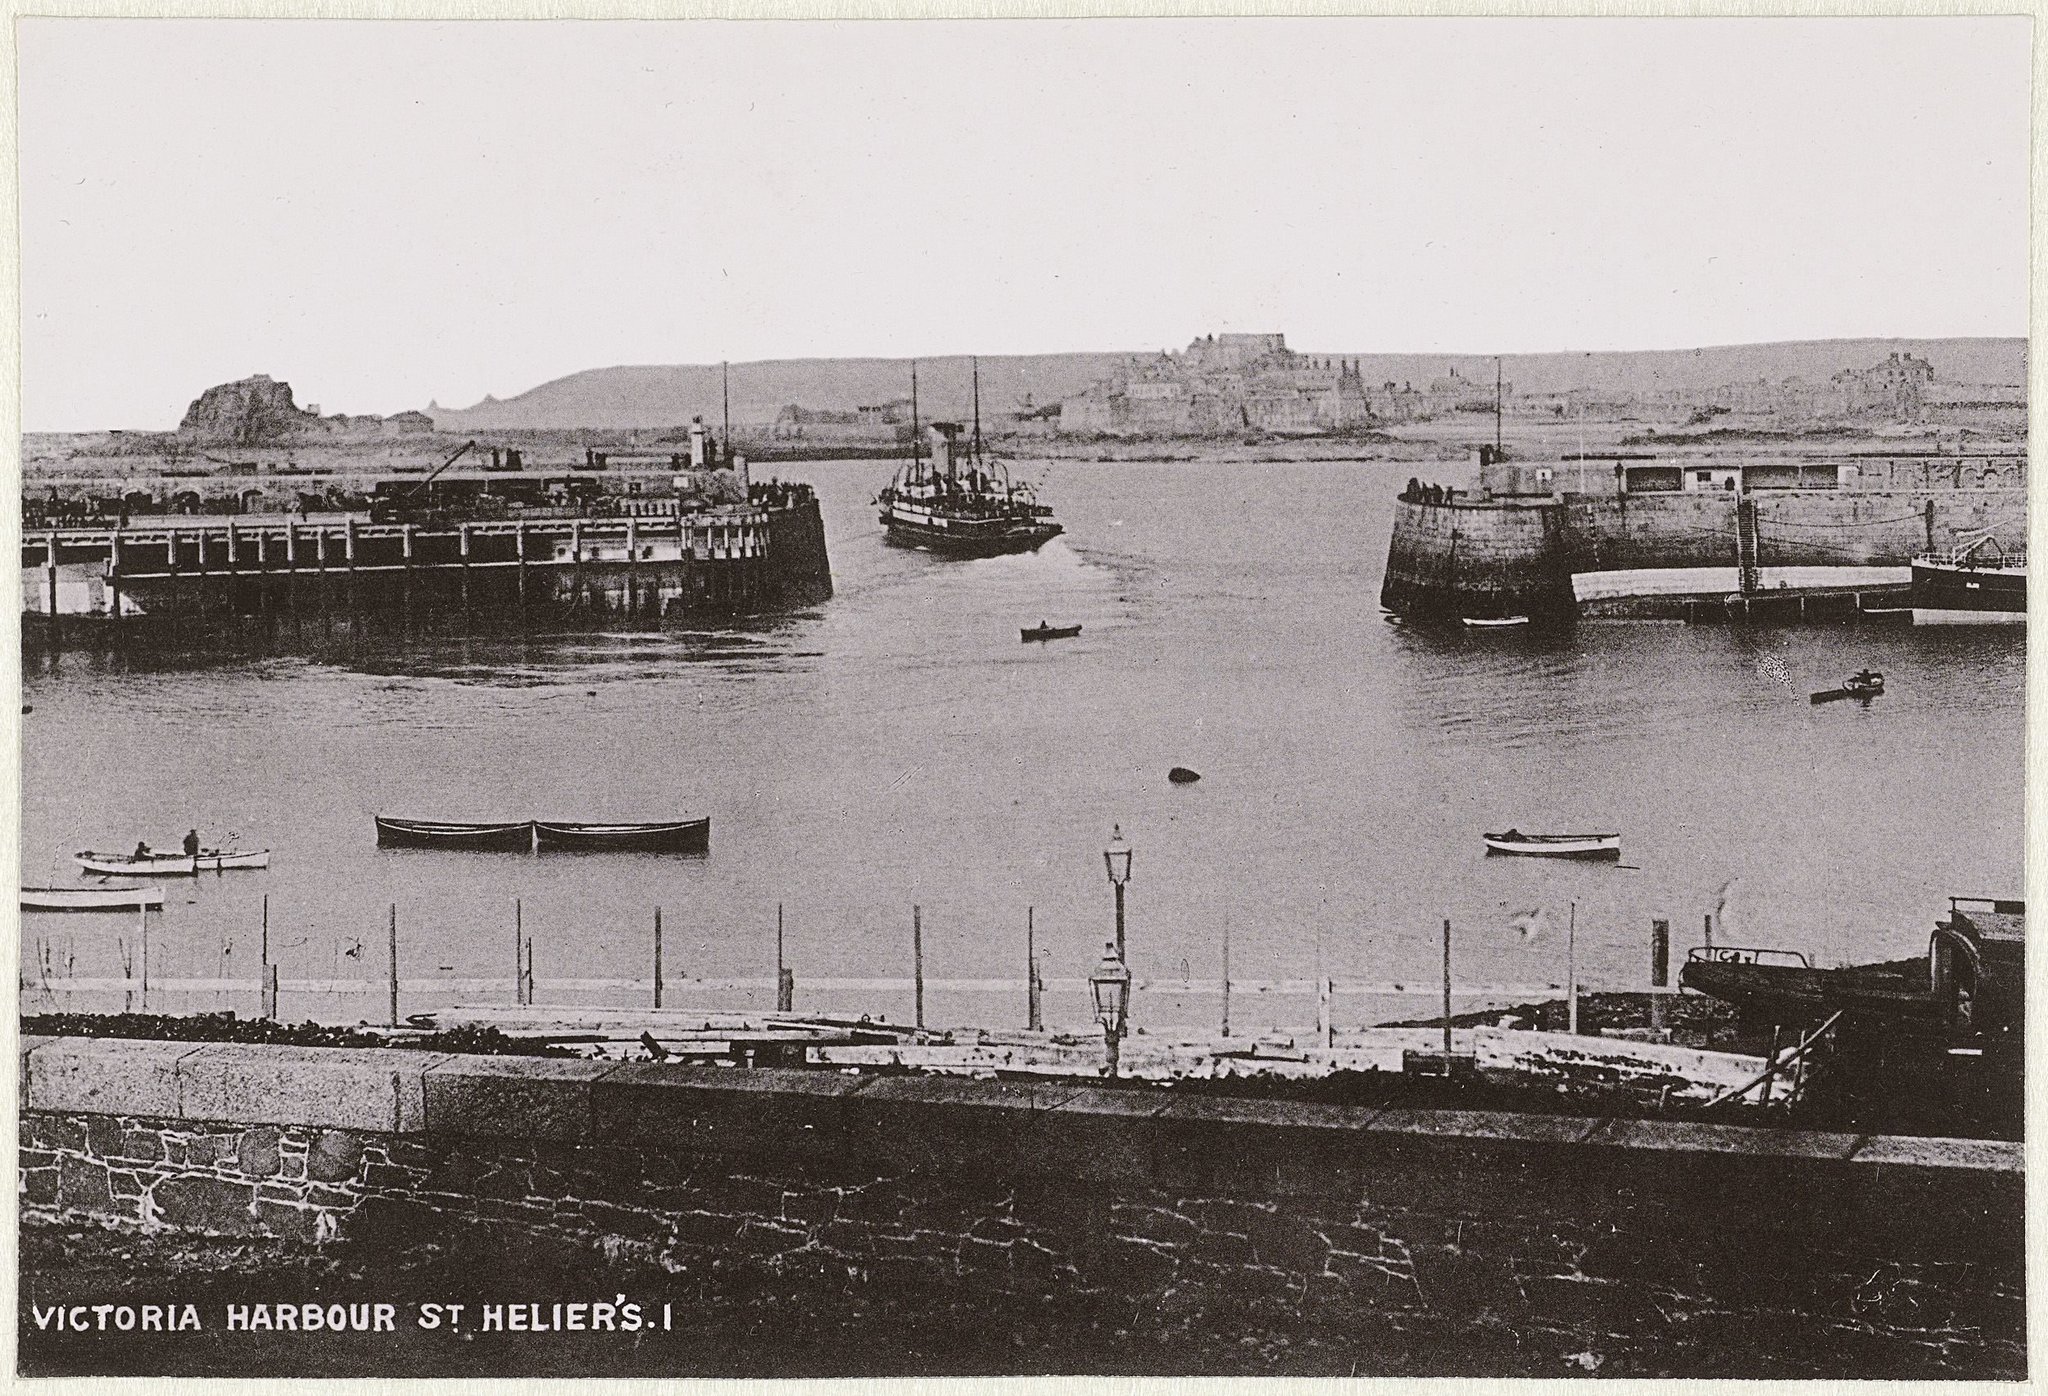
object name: photomechanical print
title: Victoria Harbour in Saint Helier te Jersey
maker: Anonymous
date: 1870-1930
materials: paper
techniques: photograph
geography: saint helier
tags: harbour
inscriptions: number: ‘1’